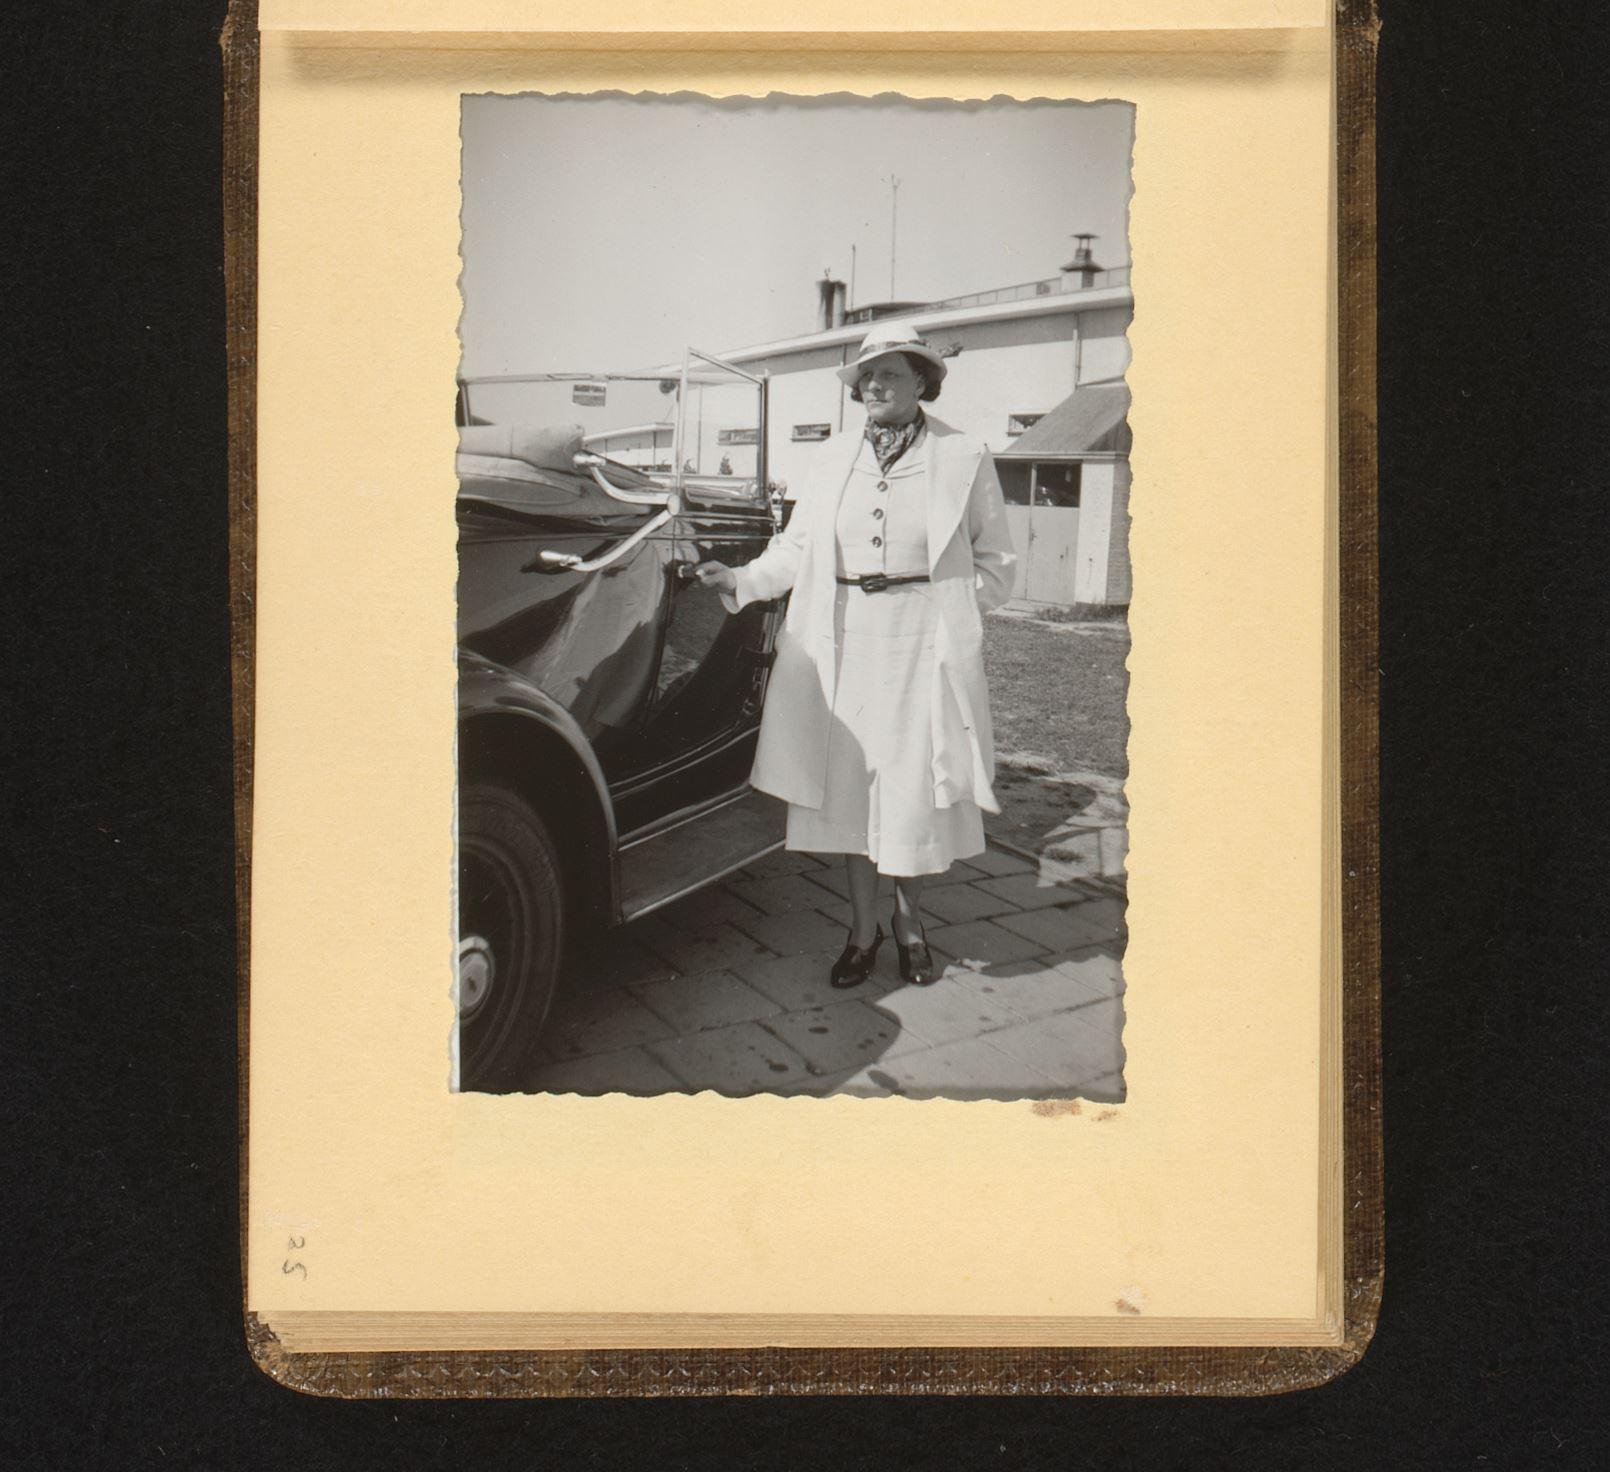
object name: photograph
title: Vrouw bij auto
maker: Anonymous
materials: cardboard, photographic support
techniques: gelatin silver print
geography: ypenburg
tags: family life at home, automobile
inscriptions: inscription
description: Albumblad met een foto van een vrouw staande naast een auto, te Ypenburg. Onderdeel van het familiealbum 1938-1939.